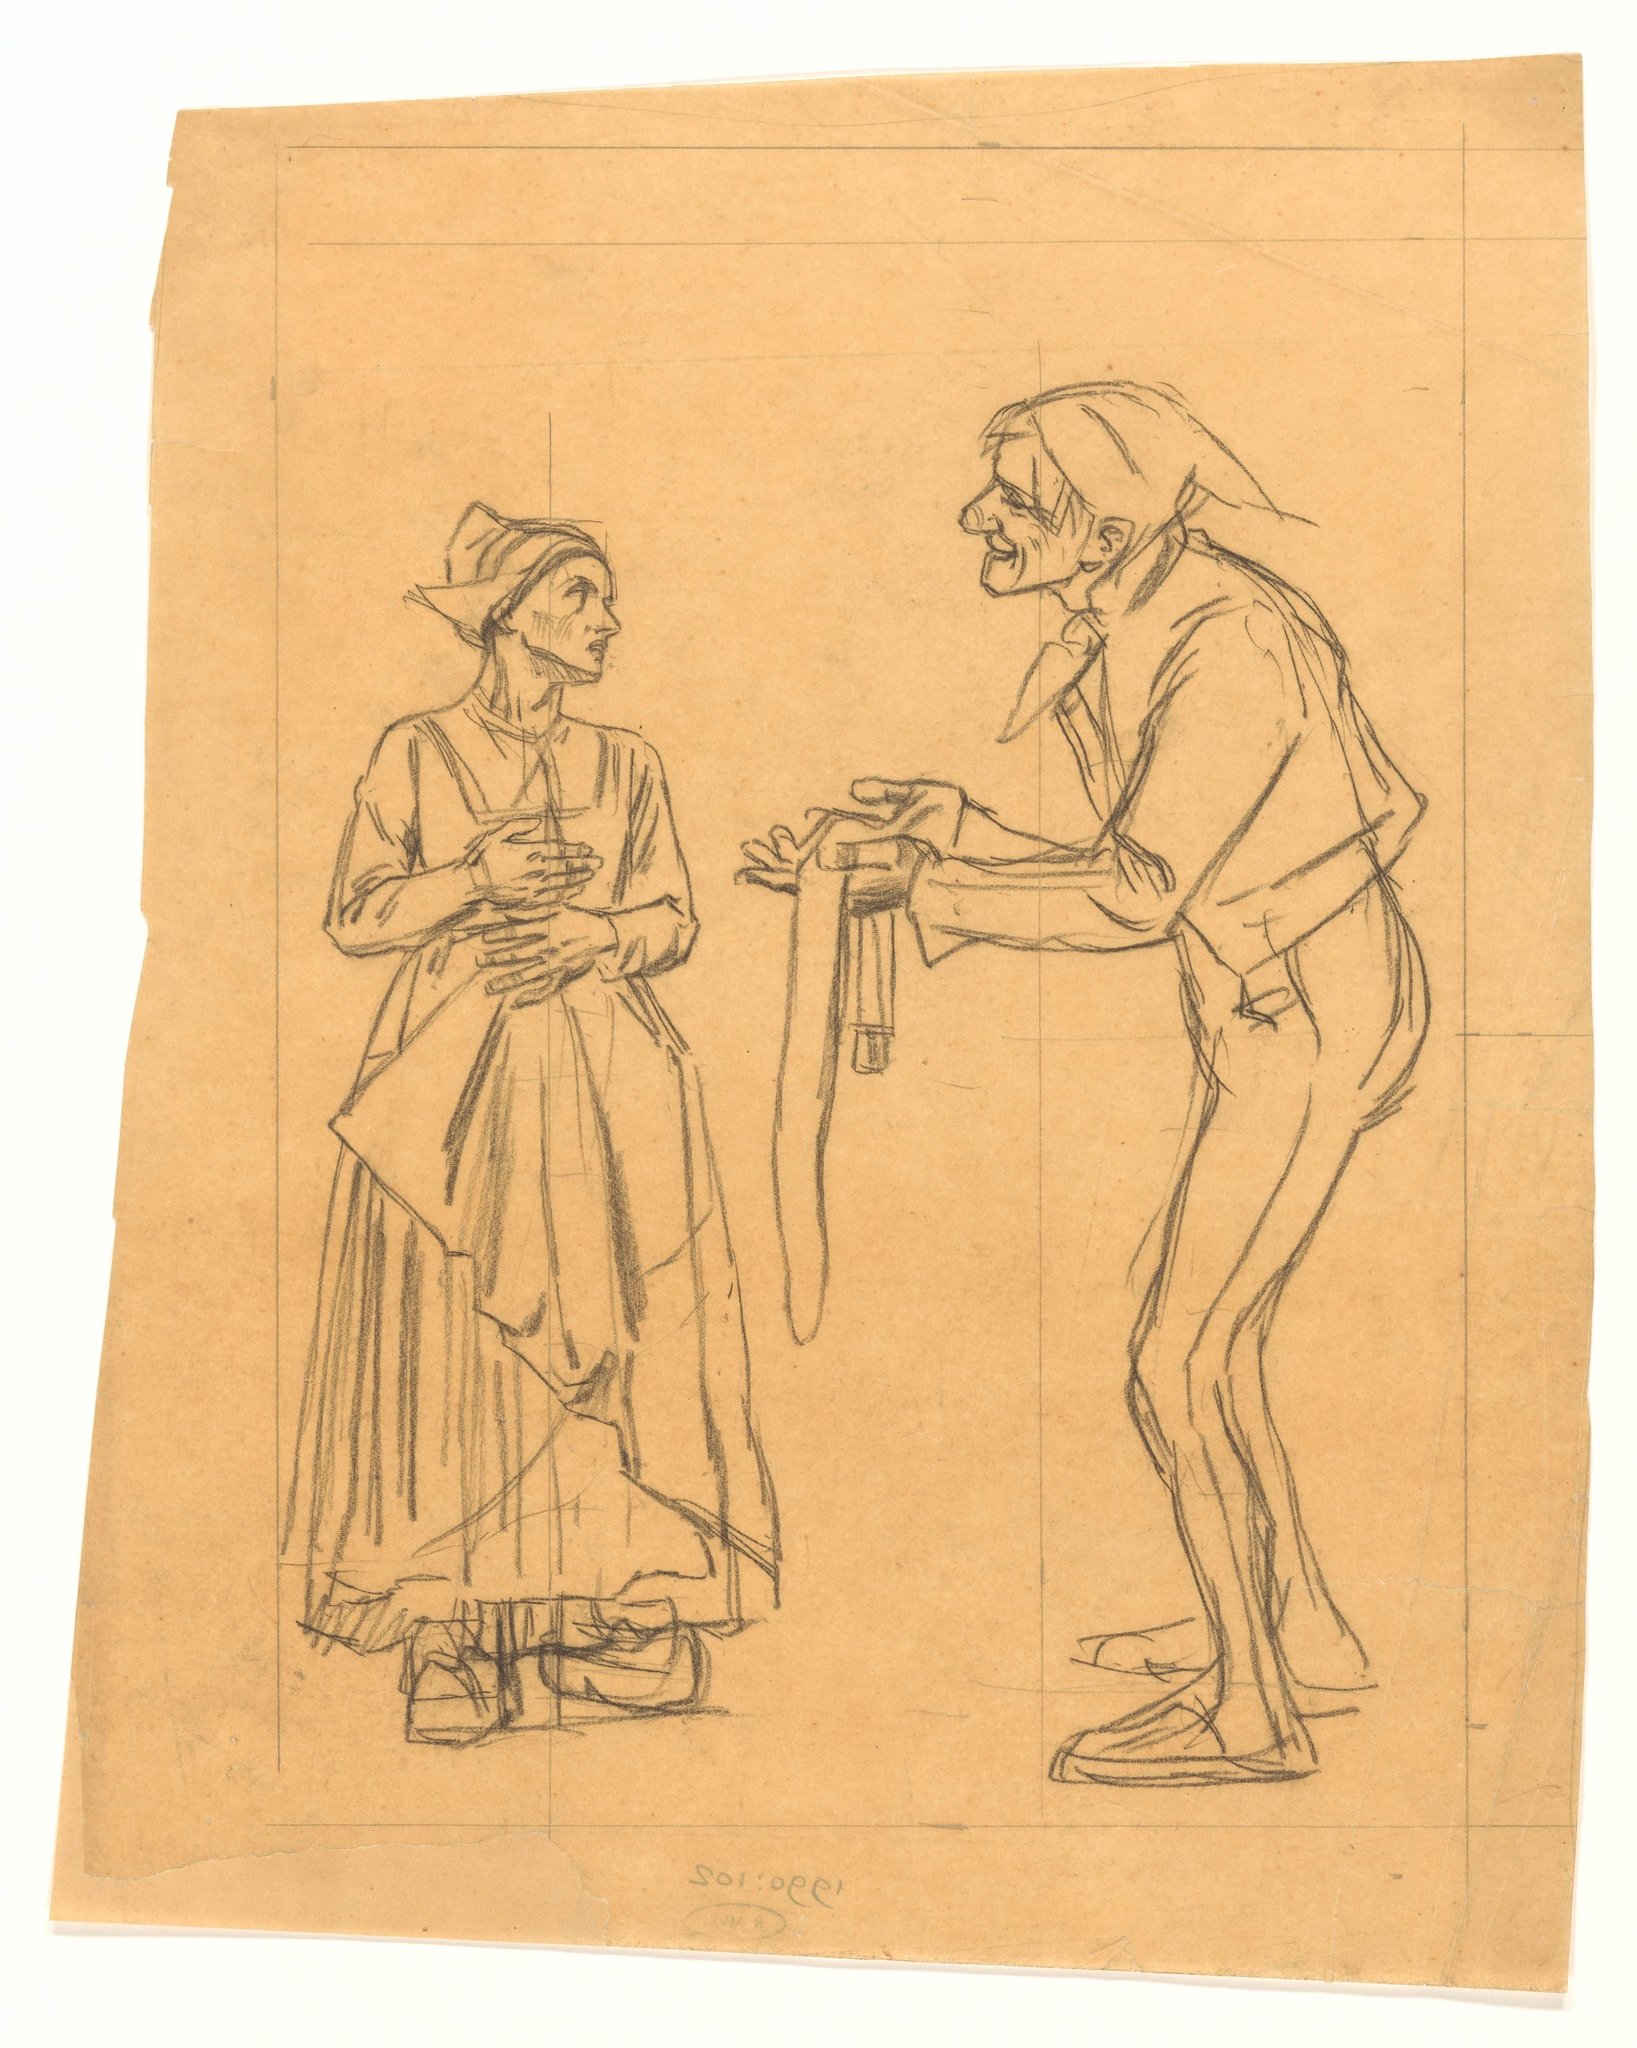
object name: drawing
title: Ontwerp voor illustratie in De Amsterdammer: een man met een riem staande voor een vrouw op klompen (6 April 1918)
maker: johan braakensiek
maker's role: draughtsman, print maker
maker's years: 1858-1940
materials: chalk, paper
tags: historical events and situations, political caricatures and satires